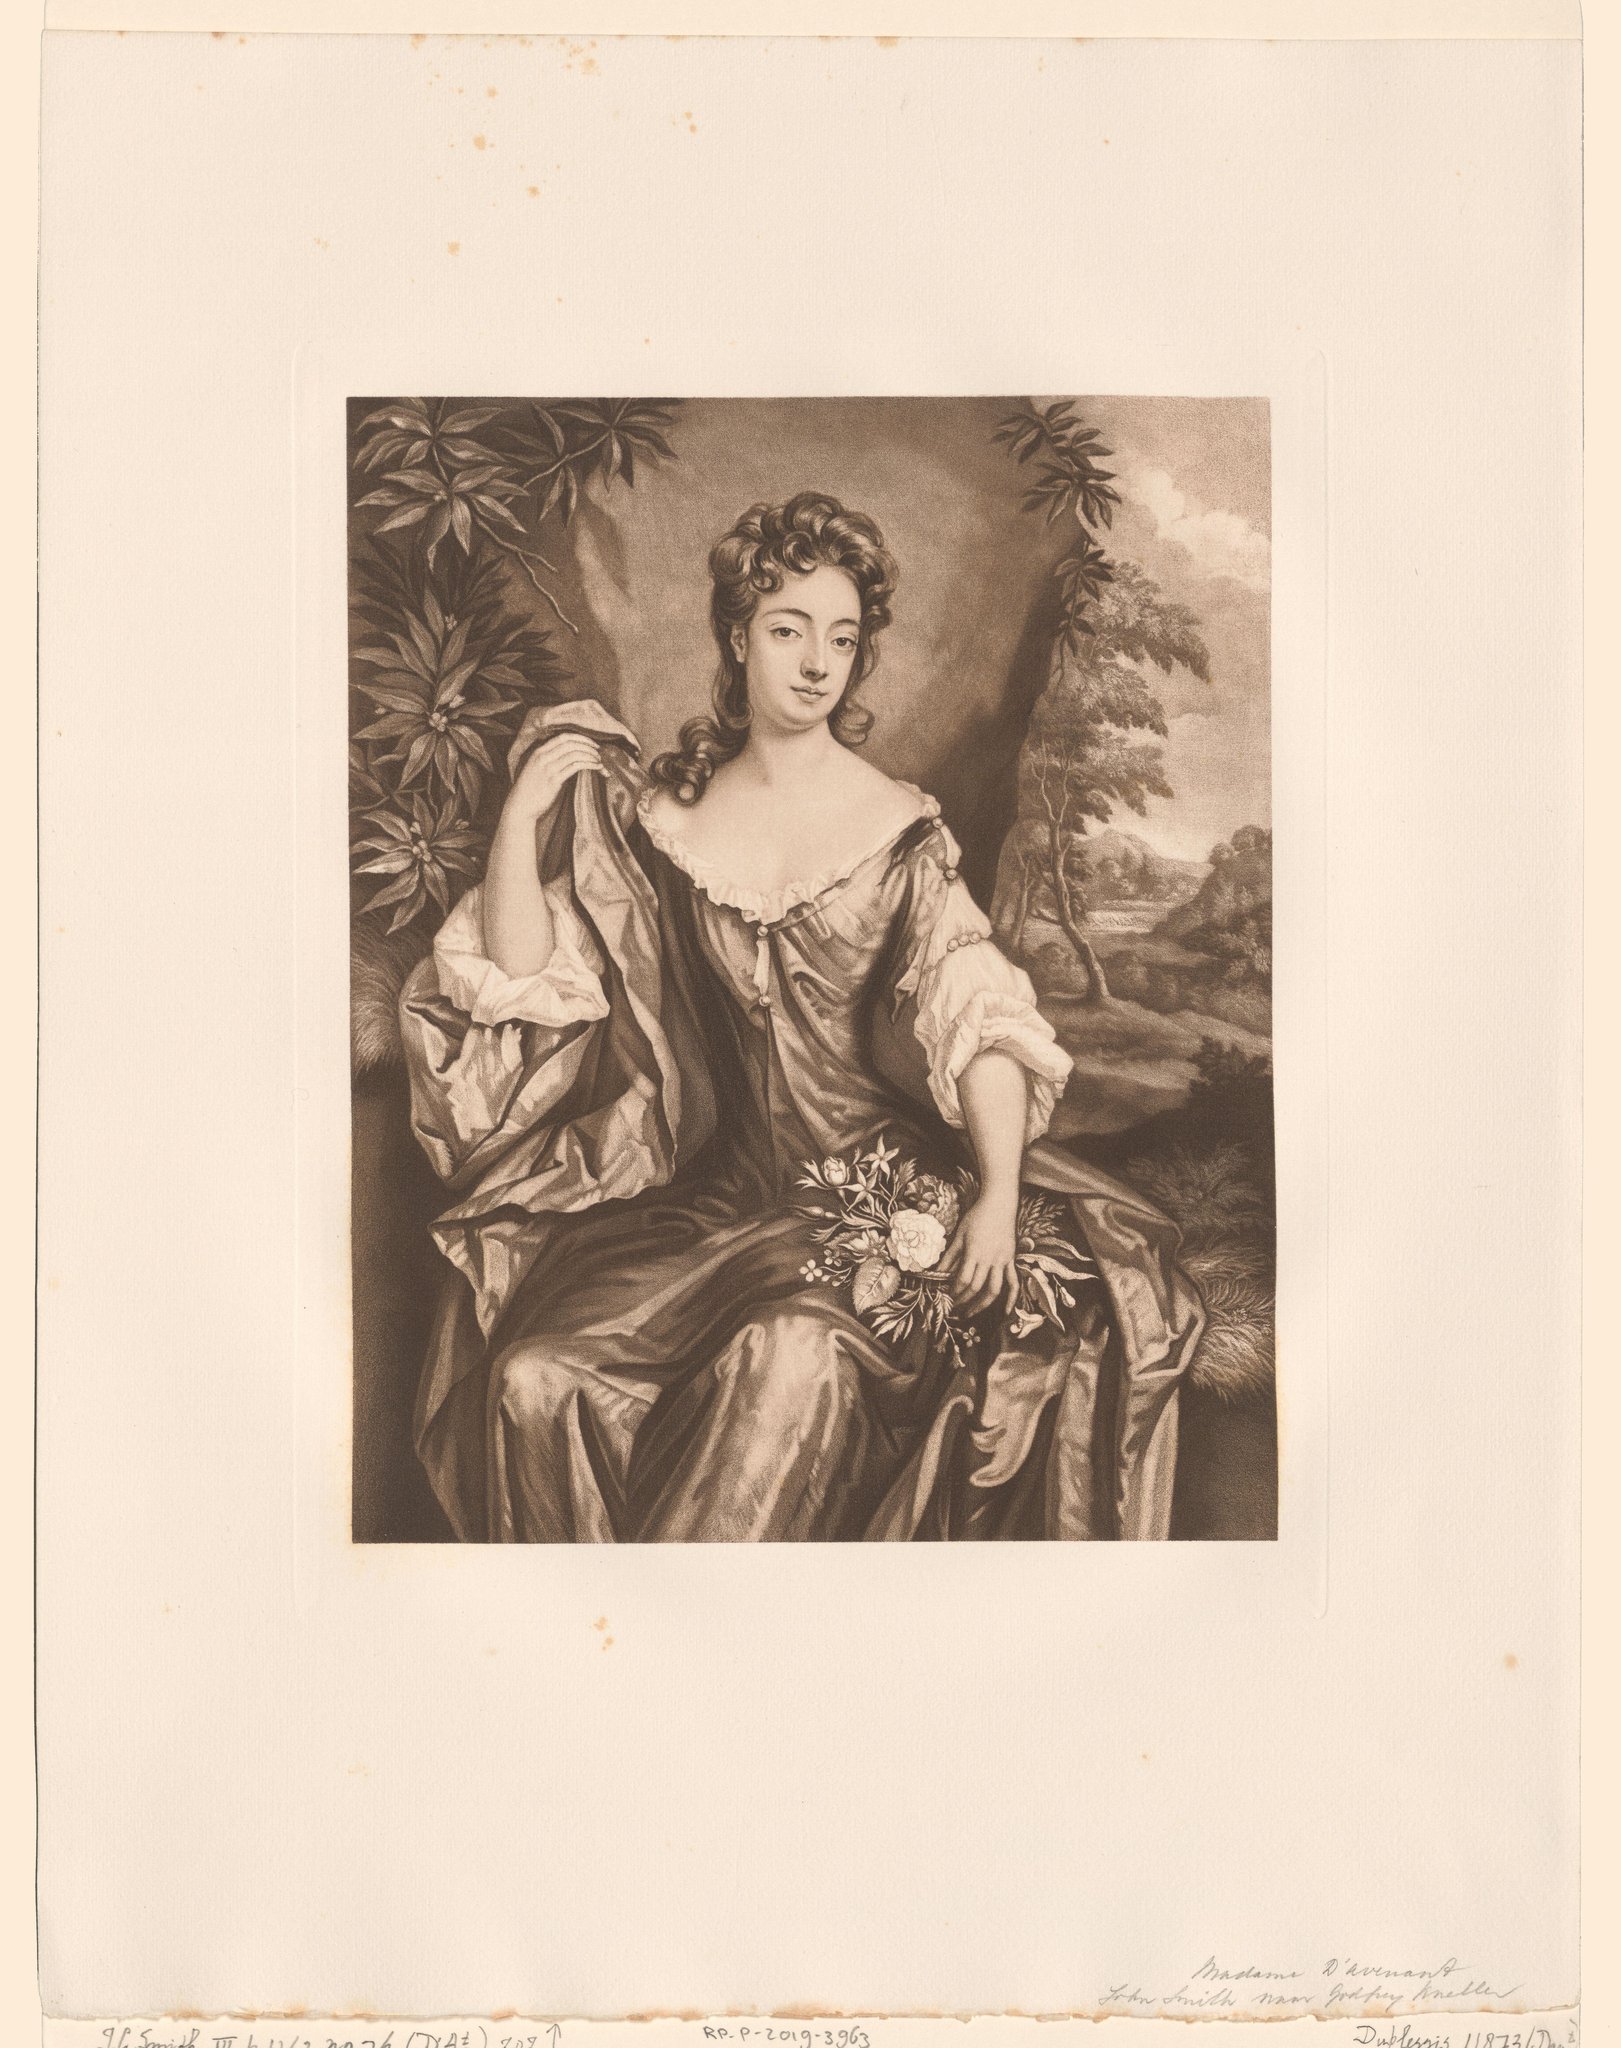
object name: photomechanical print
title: Portret van Frances Davenant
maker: Anonymous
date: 1850-1899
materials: paper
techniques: photoaquatint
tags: historical persons - bb - woman